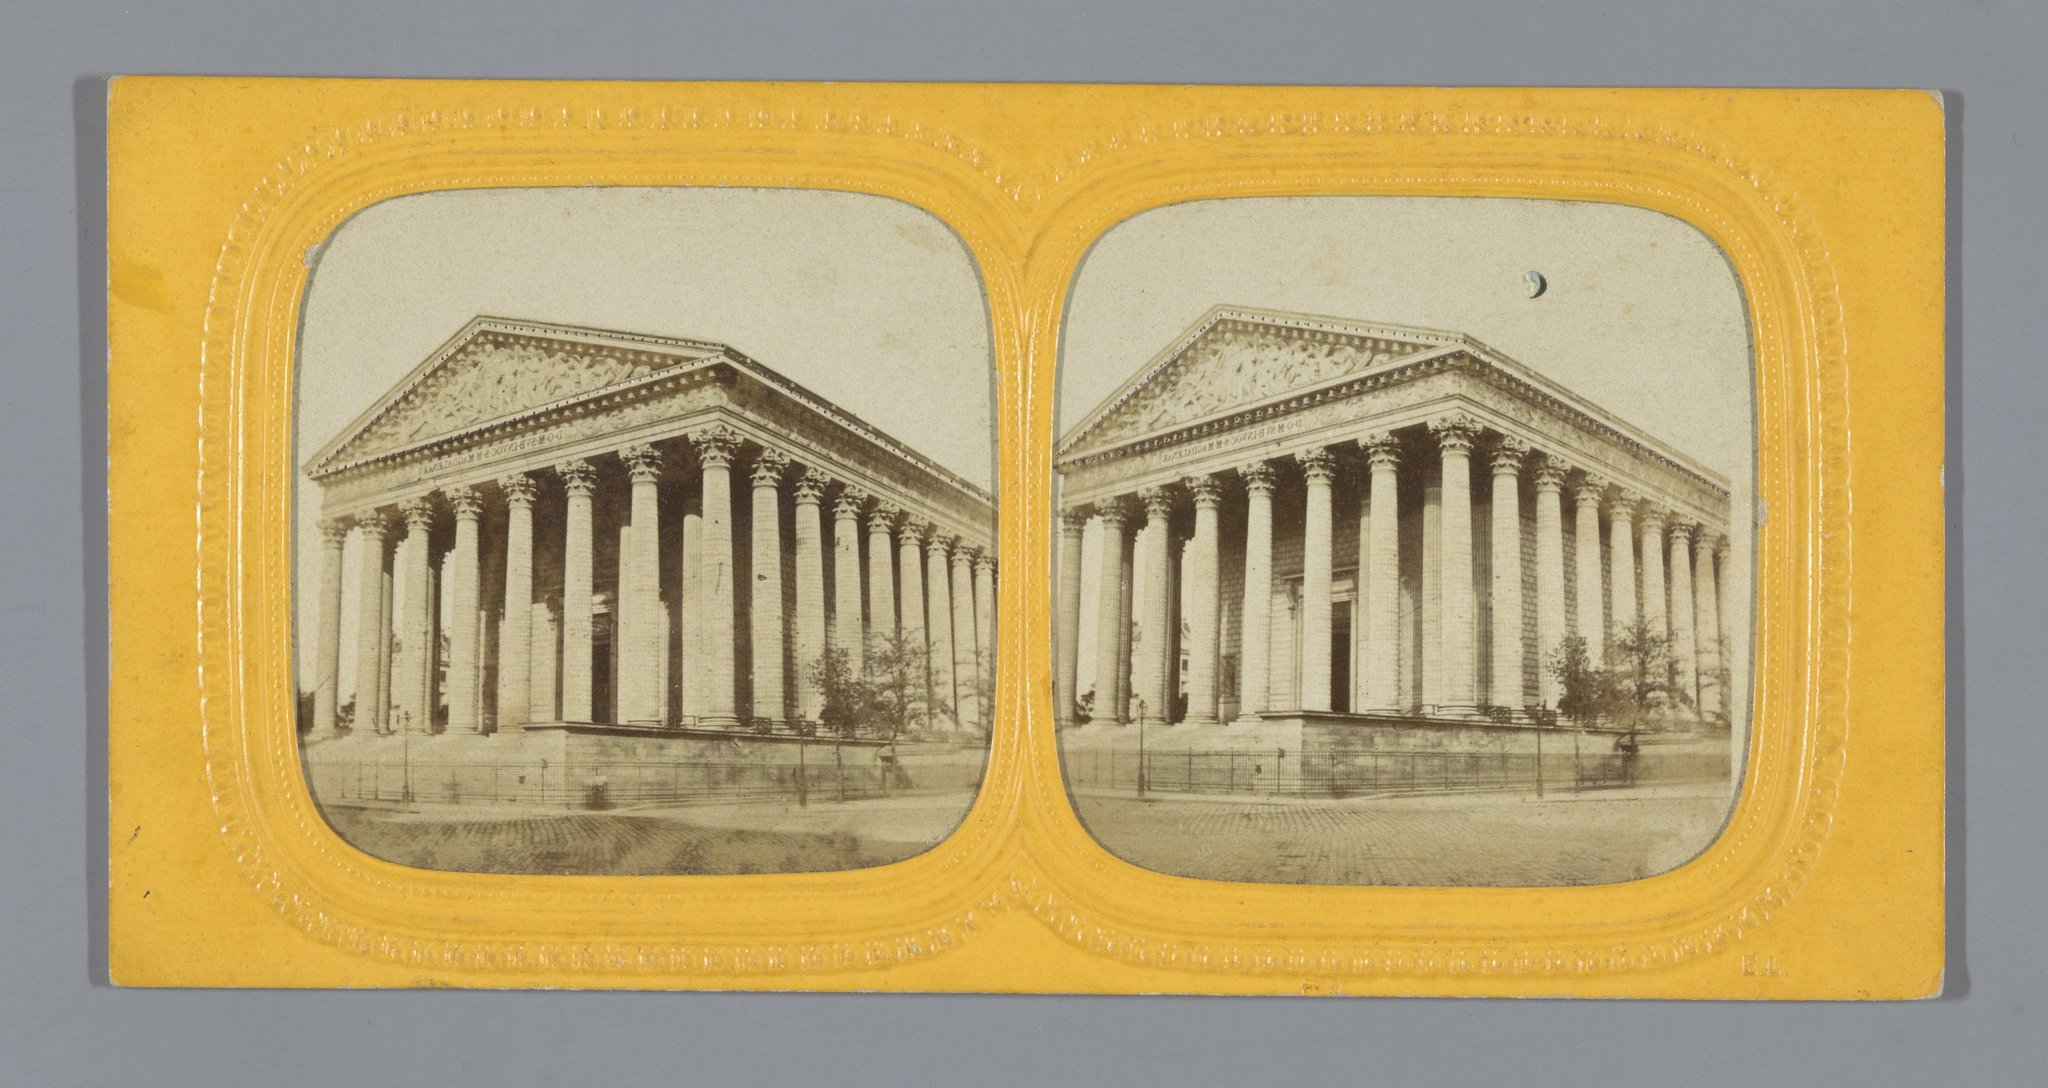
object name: tissue stereograph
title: La Madeleine, Paris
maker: Anonymous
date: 1855-1875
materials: cardboard, paper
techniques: albumen print, hand coloring, perforating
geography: paris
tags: column, pillar ~ architecture, parts of church exterior and annexes: tympanum, parts of church exterior and annexes: façade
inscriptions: monogram: ‘E.L.’